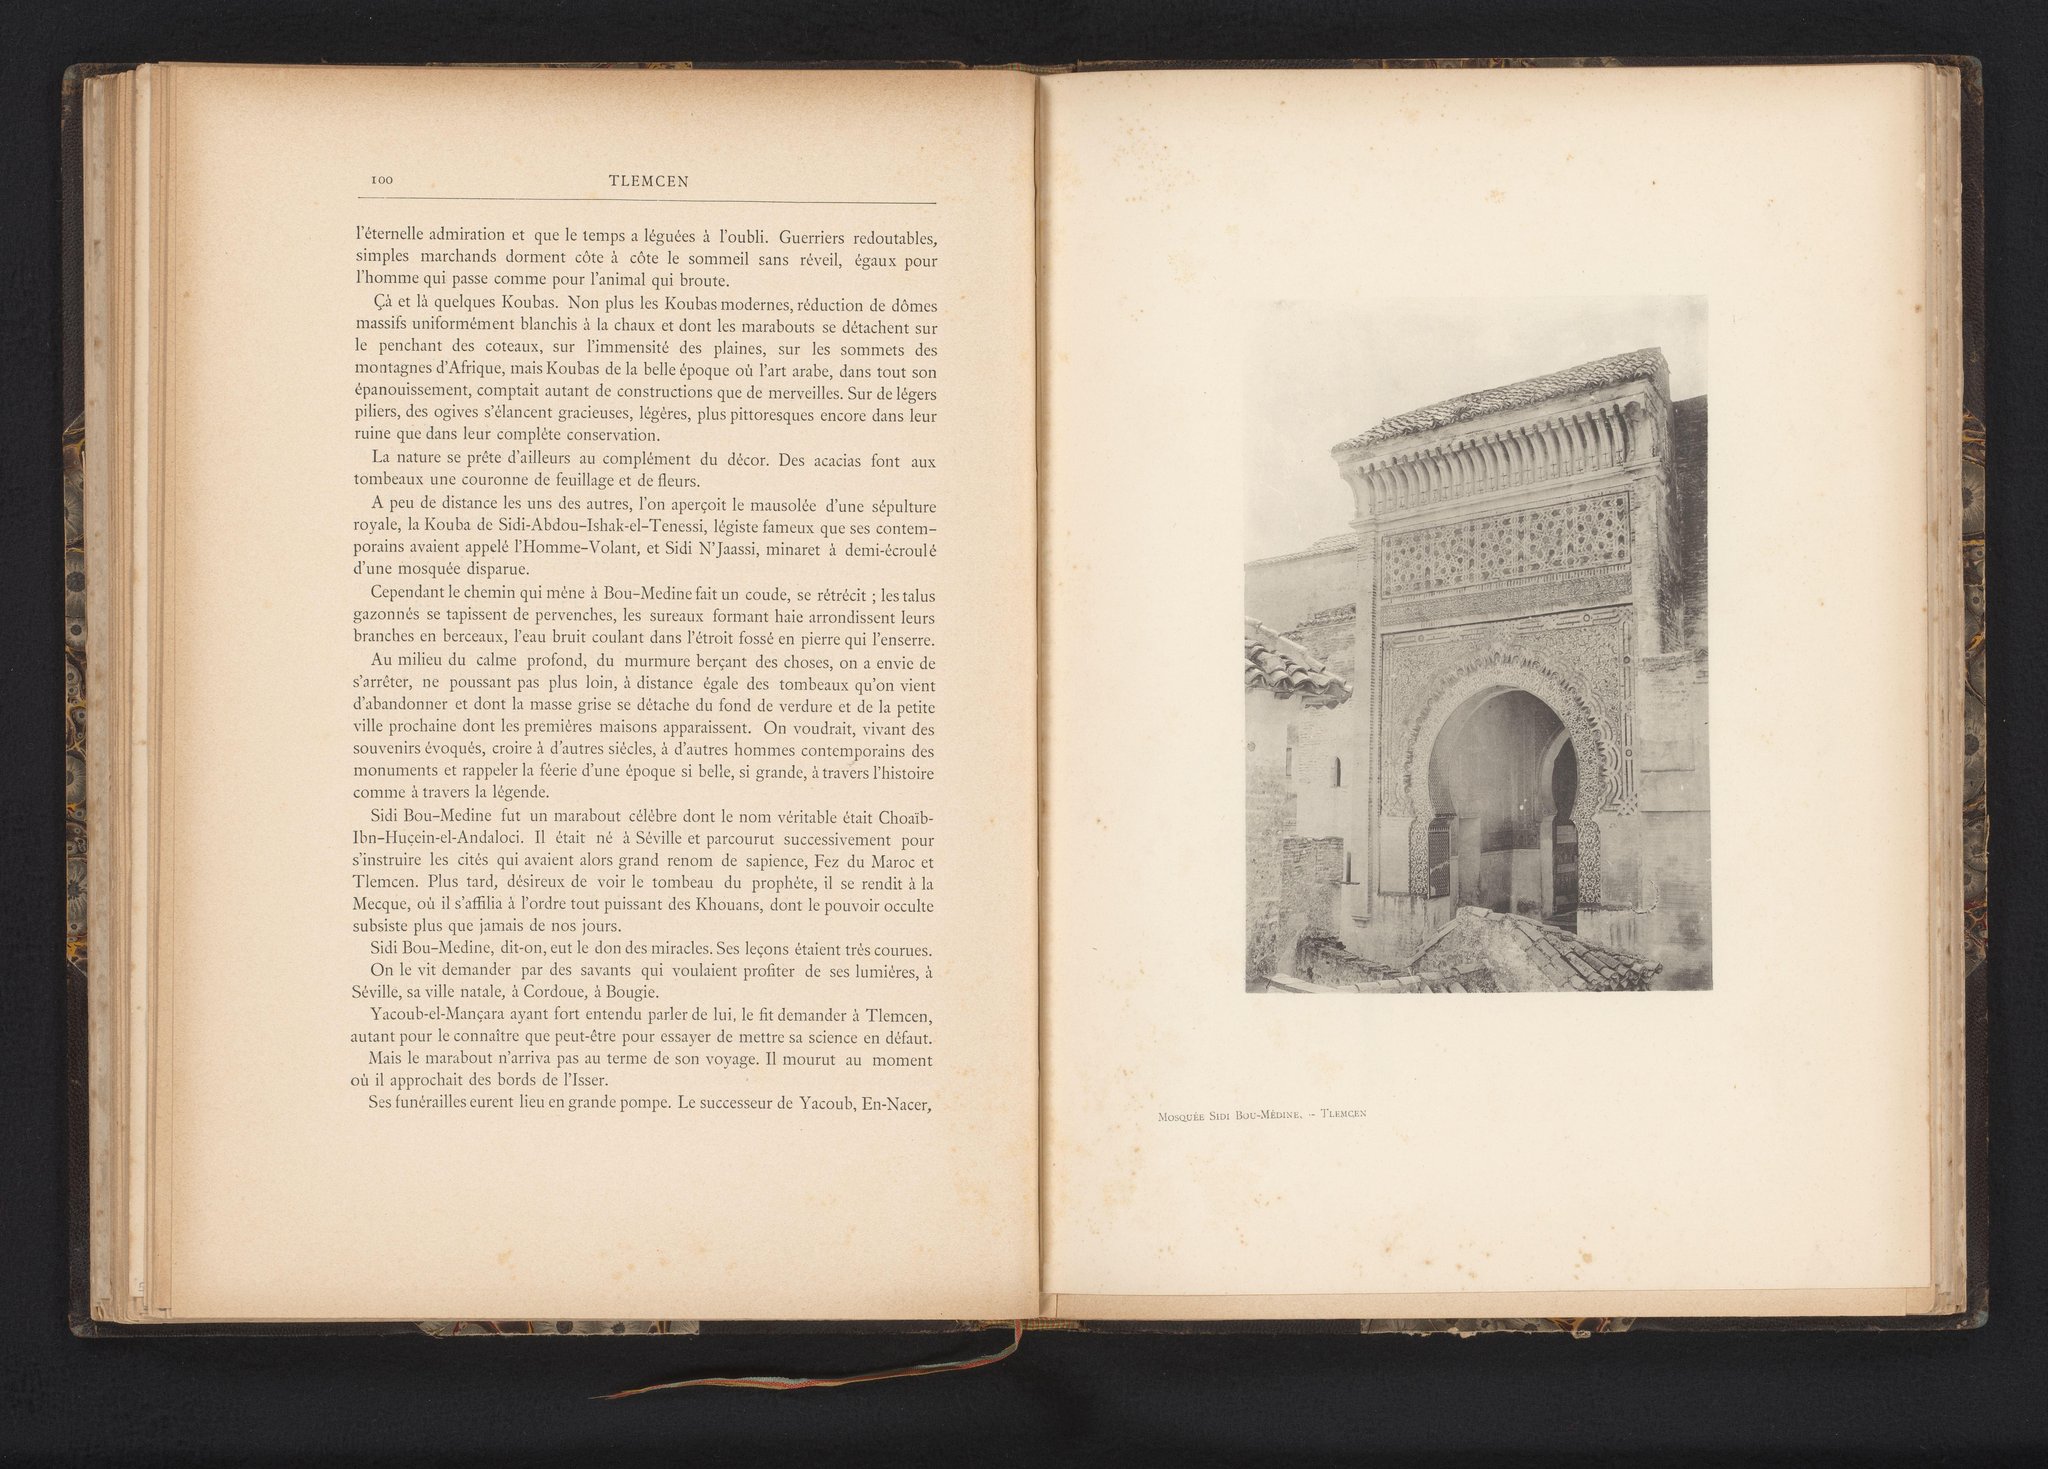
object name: page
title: Gezicht op de Sidi Boumediene moskee in Tlemcen, Algerije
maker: jules gervais-courtellemont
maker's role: fotograaf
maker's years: 1863-1931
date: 1888-1893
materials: paper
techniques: photograph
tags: temple, shrine ~ islam, mohammedanism